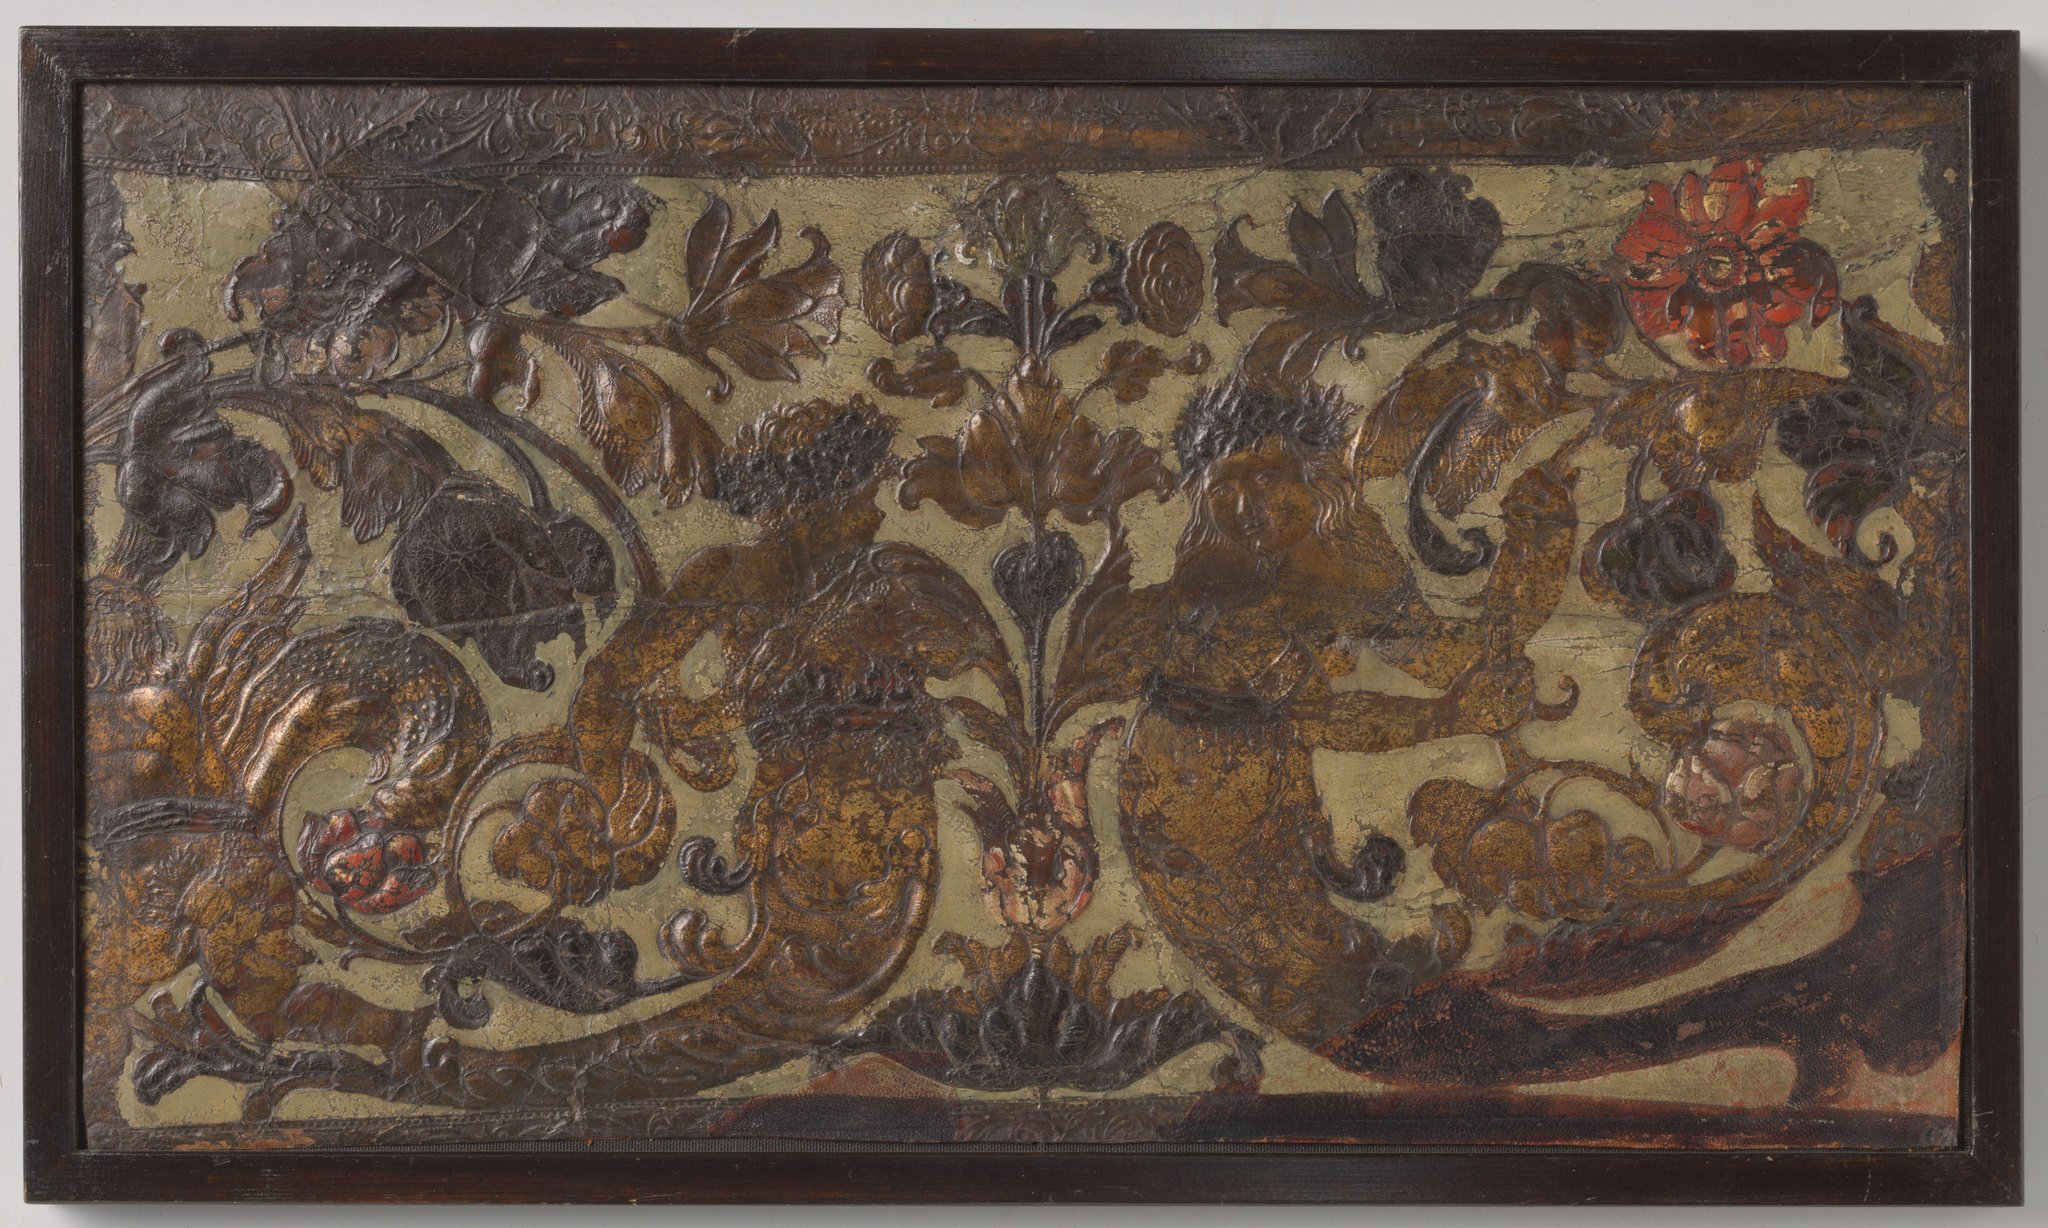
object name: gilt leather hanging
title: Boord van verheven goudleer, gedecoreerd met twee naar elkaar toegewende zeewezens, bloem- en bladranken in een symmetrische opbouw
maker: Anonymous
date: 1652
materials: gilt leather, leather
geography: the hague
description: Boord van verheven goudleer, gedecoreerd met twee naar elkaar toegewende zeewezens, bloem- en bladranken in een symmetrische opbouw. Aan boven- en onderzijde (delen van) een smalle ornamentale rand. Beschildering in rood en bruin (ooit groen) op grijs/groene grond. Gevat in moderne houten lijst.